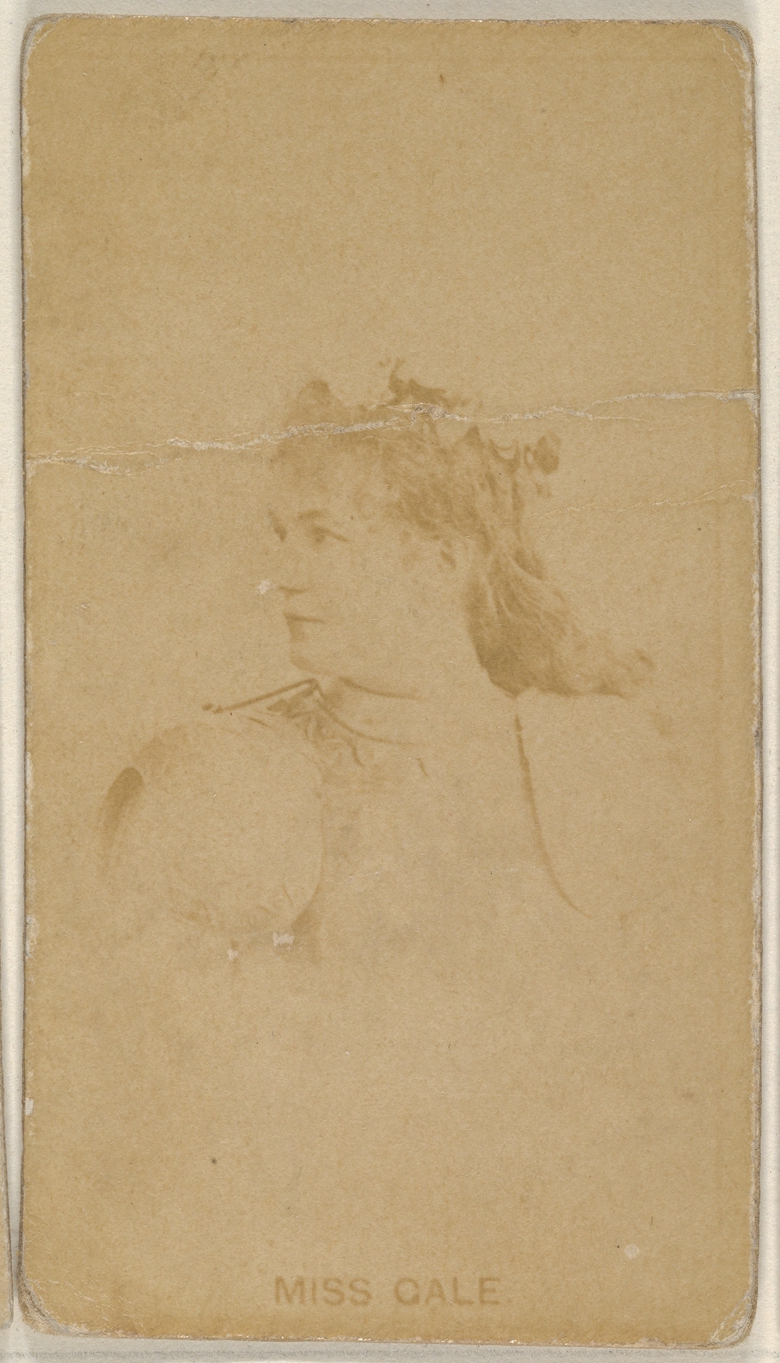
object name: photograph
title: Miss Gale, from the Actors and Actresses series (N45, Type 8) for Virginia Brights Cigarettes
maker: allen & ginter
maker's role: publisher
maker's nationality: american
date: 1888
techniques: albumen silver print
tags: portraits,women,actresses